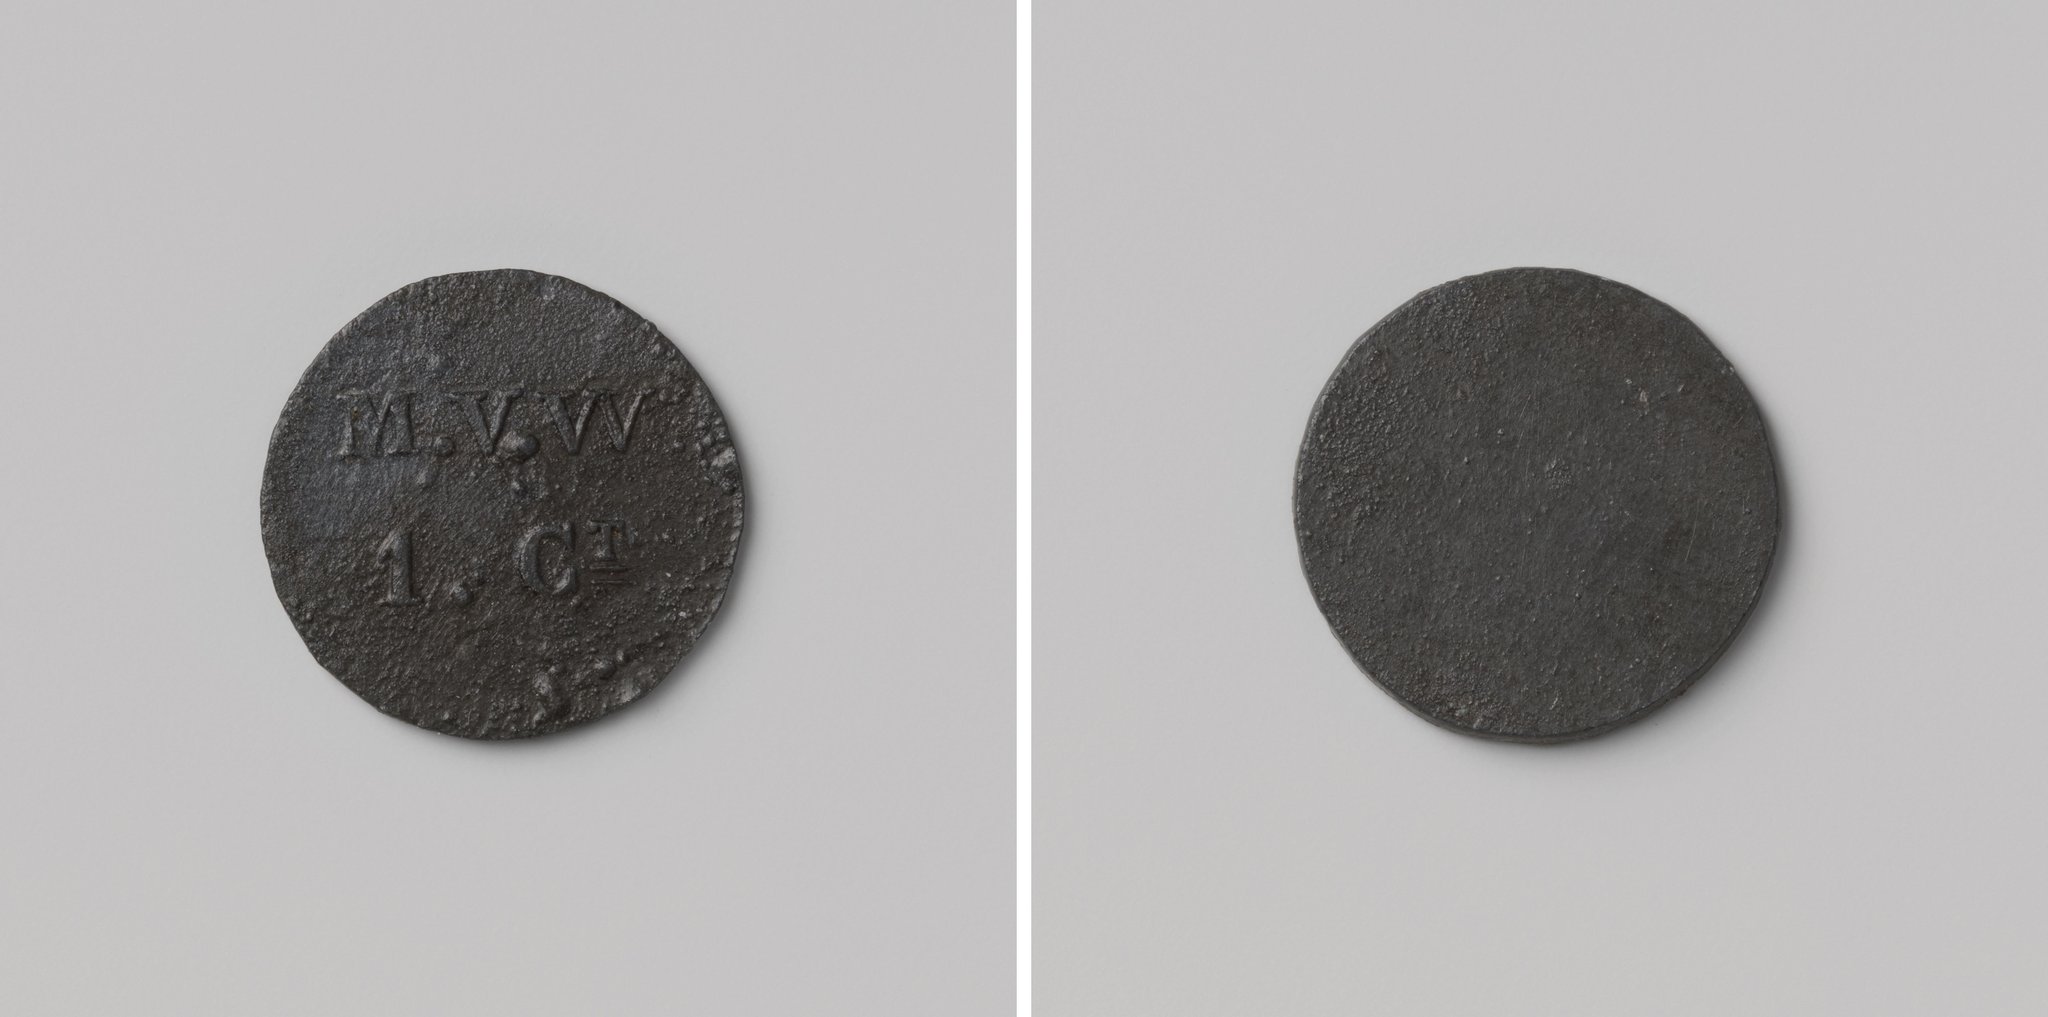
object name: huismunt prison money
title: Huismunt geslagen op last van de Maatschappij van Weldadigheid ter waarde van 1 cent, ten behoeve van de Gewone Koloniën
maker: Anonymous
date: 1818-1859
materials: zinc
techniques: striking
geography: netherlands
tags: maatschappij van weldadigheid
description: Eenzijdige zinken munt. Voorzijde: opschrift boven waardeaanduiding. Keerzijde: blanco